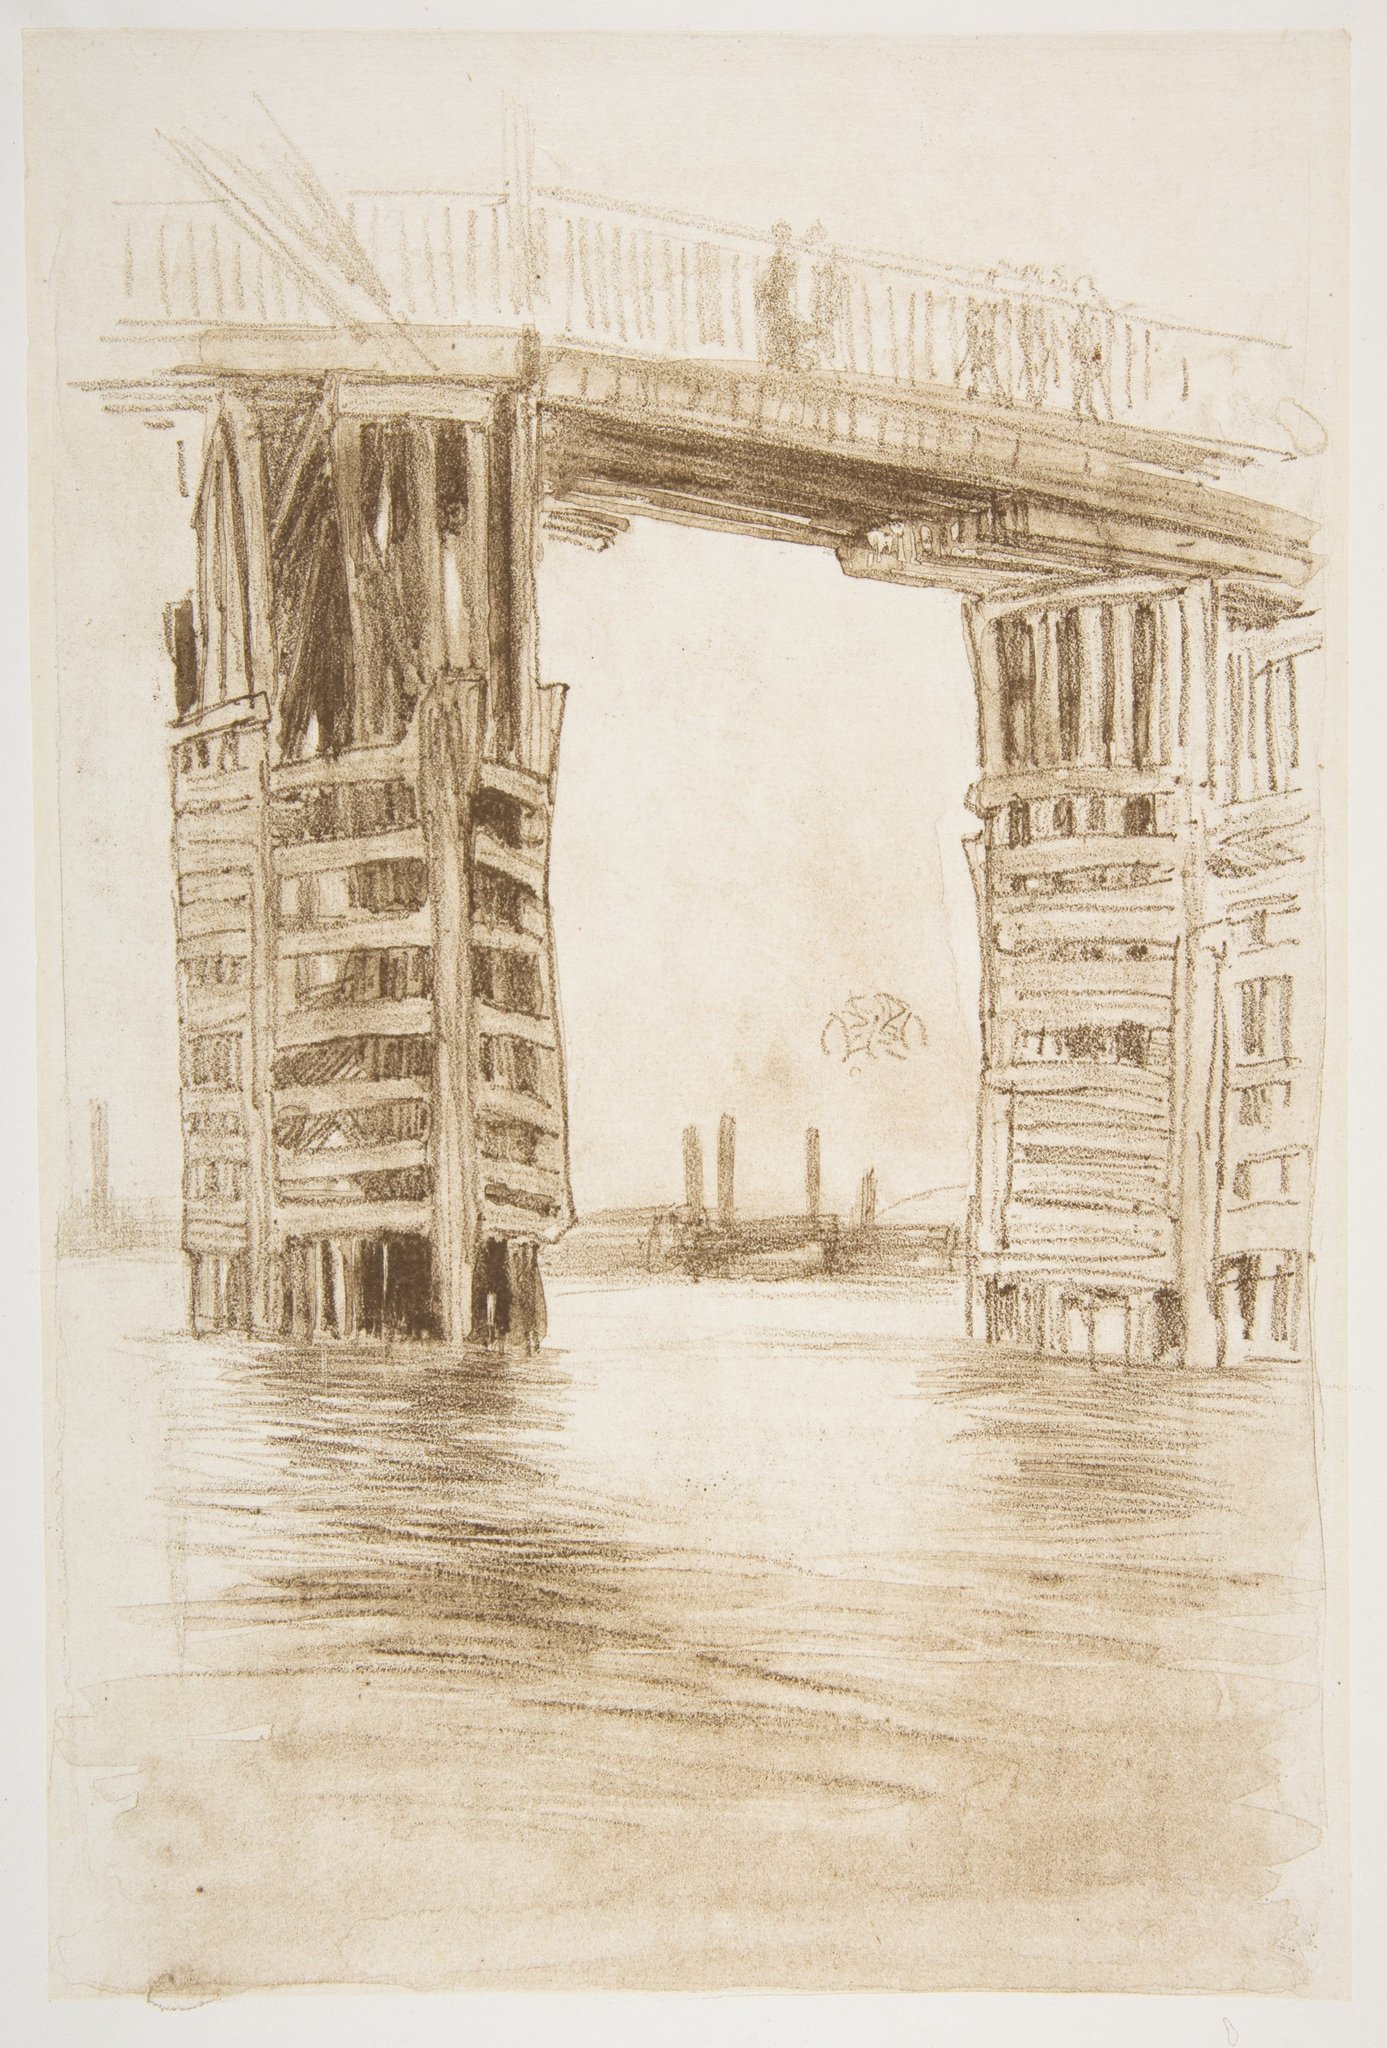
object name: print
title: The Tall Bridge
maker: james mcneill whistler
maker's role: artist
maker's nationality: american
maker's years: 1834-1903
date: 1878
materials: ink, paper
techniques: printing, scraping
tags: bridges